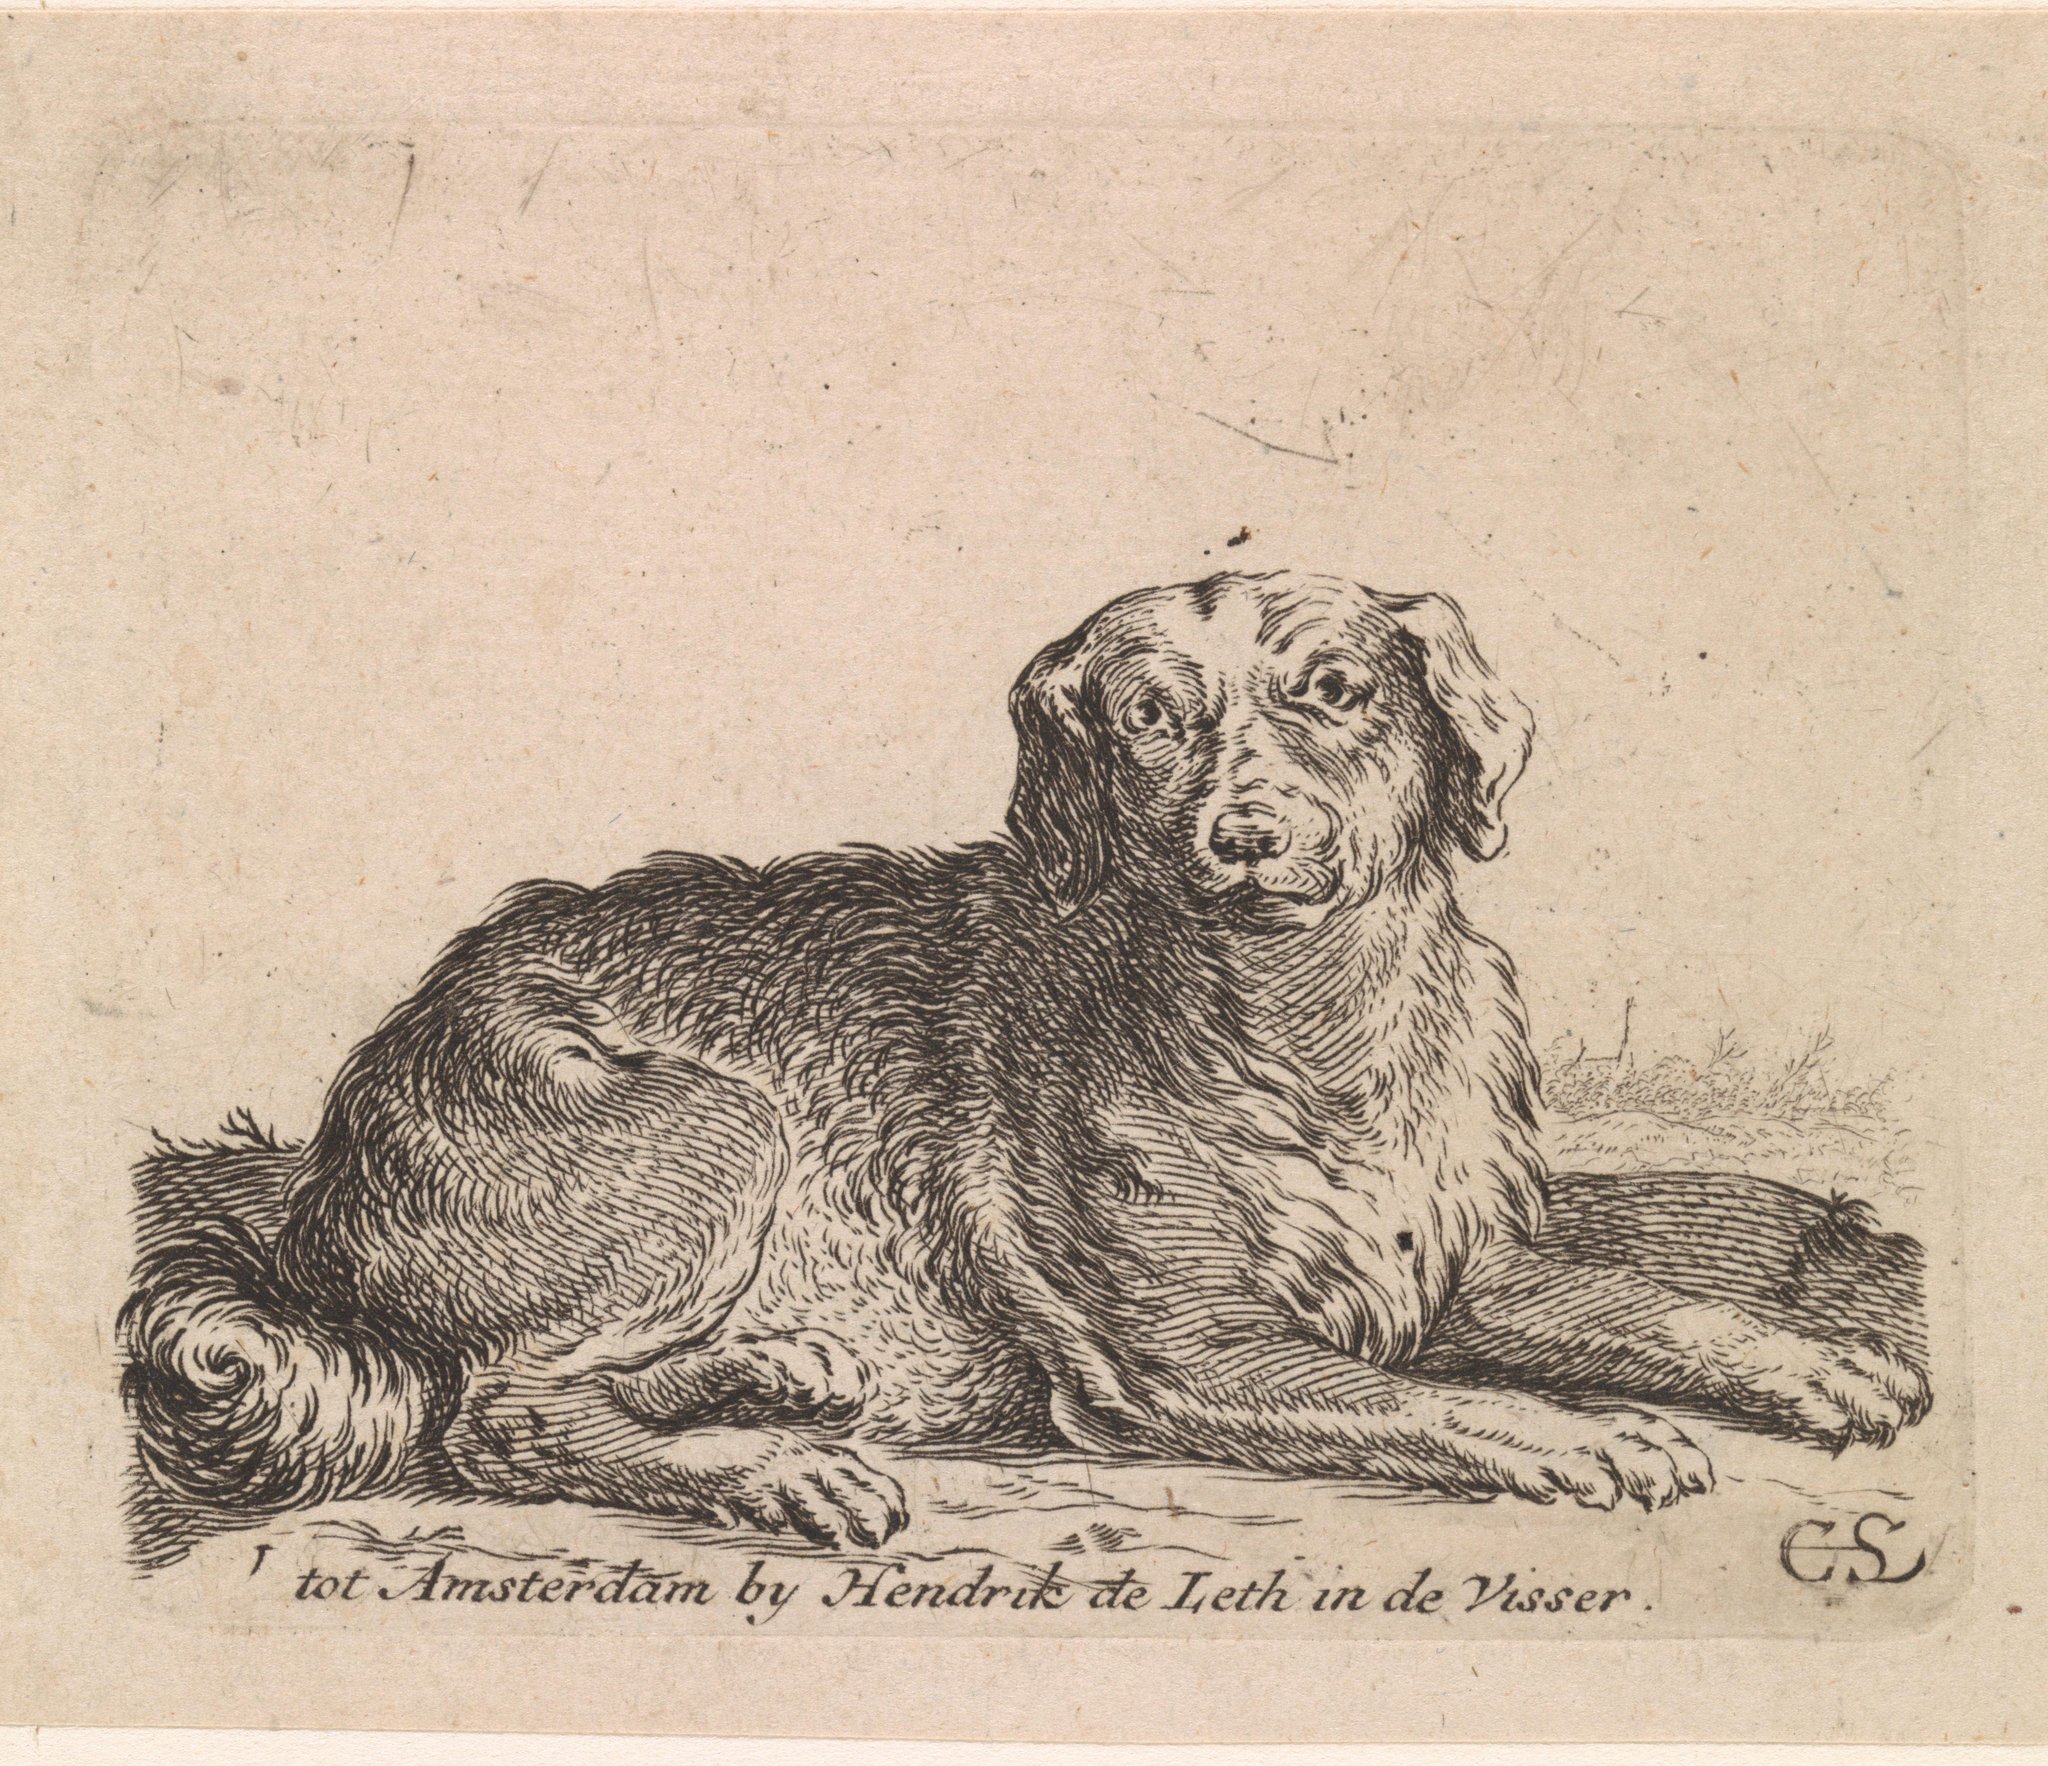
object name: print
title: Liggende hond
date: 1725-1747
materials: paper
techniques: etching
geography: amsterdam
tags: landscapes, dog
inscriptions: collector's mark: Lugt 2228